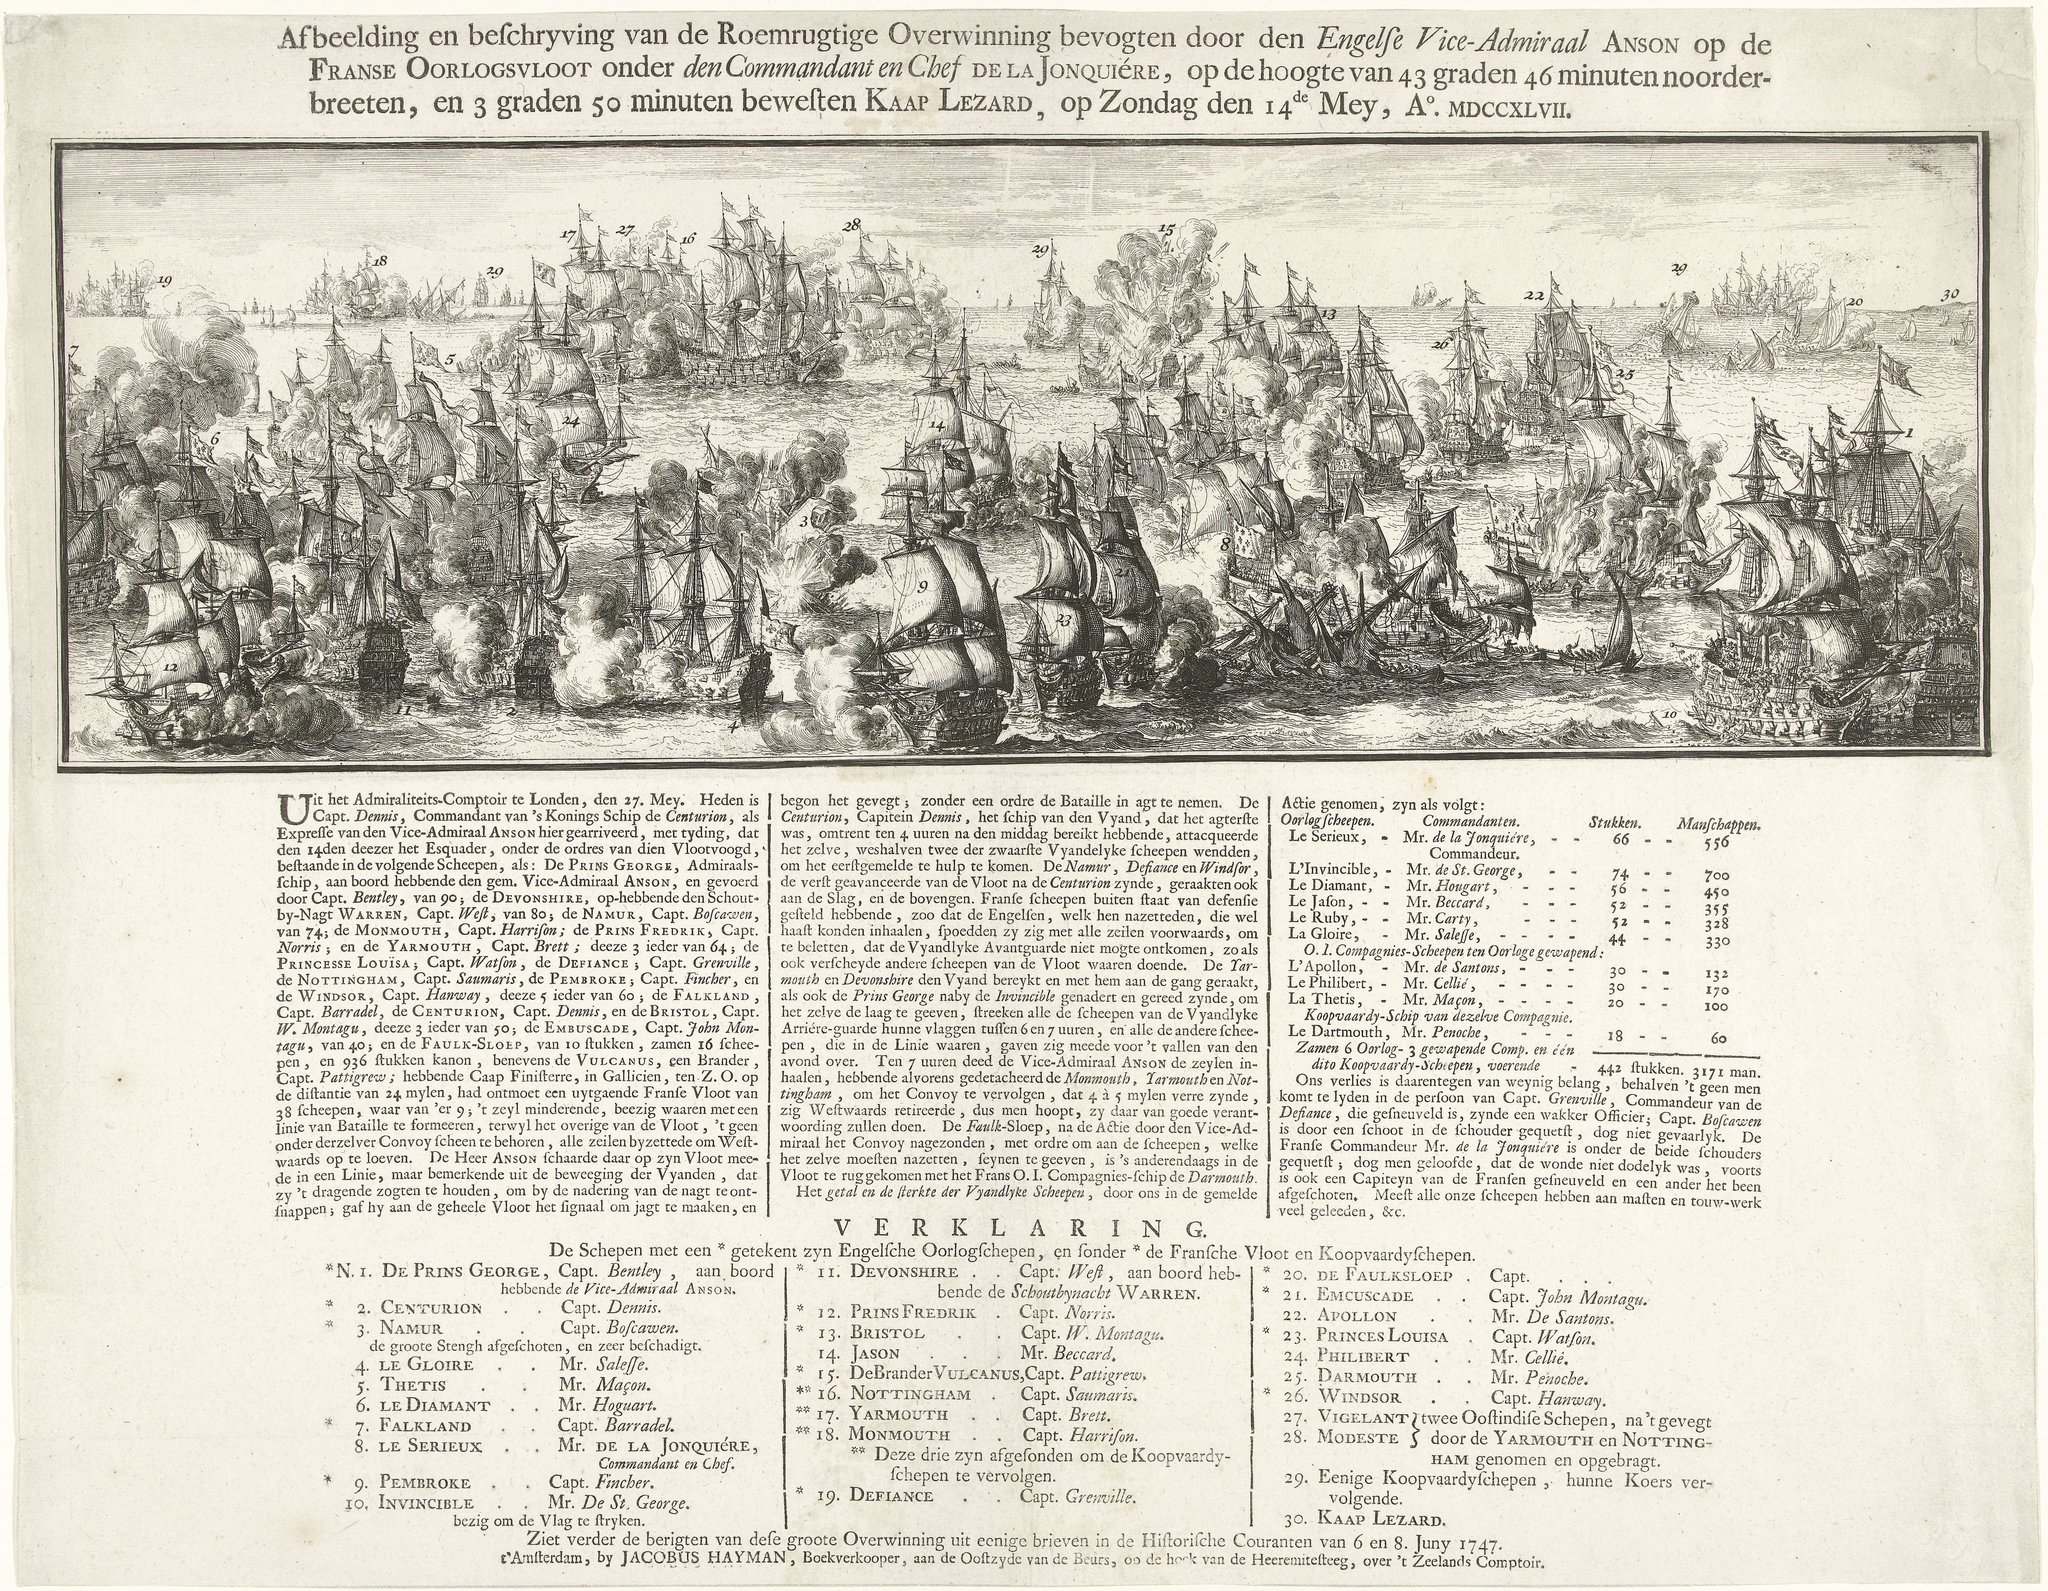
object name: print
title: Afbeelding en beschryving van de Roemrugtige Overwinning bevogten door den Engelsche Vice-Admiraal Anson op de Franse Oorlogsvloot onder den Commandant en Chef De La Jonquiére (...) bewesten Kaap Lezard, op Zondag den 14de Mey, Ao. MDCCXLVII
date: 1692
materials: paper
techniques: etching, letterpress printing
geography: amsterdam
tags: battle (+ naval force)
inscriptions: collector's mark: Lugt 2228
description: Zeeslag bij Kaap Lezard (Kaap Finisterre) waarbij de Engelse vloot onder admiraal George Anson een overwinning behaalde op de Franse vloot onder admiraal de la Jonquiére, 14 mei 1747. Op het blad onder de plaat een beschrijving van de slag in drie kolommen met een lijst van de genomen Franse schepen met aantallen geschut en manschappen, onderaan een verklaring van de cijfers 1-30 van de Engelse en Franse schepen.